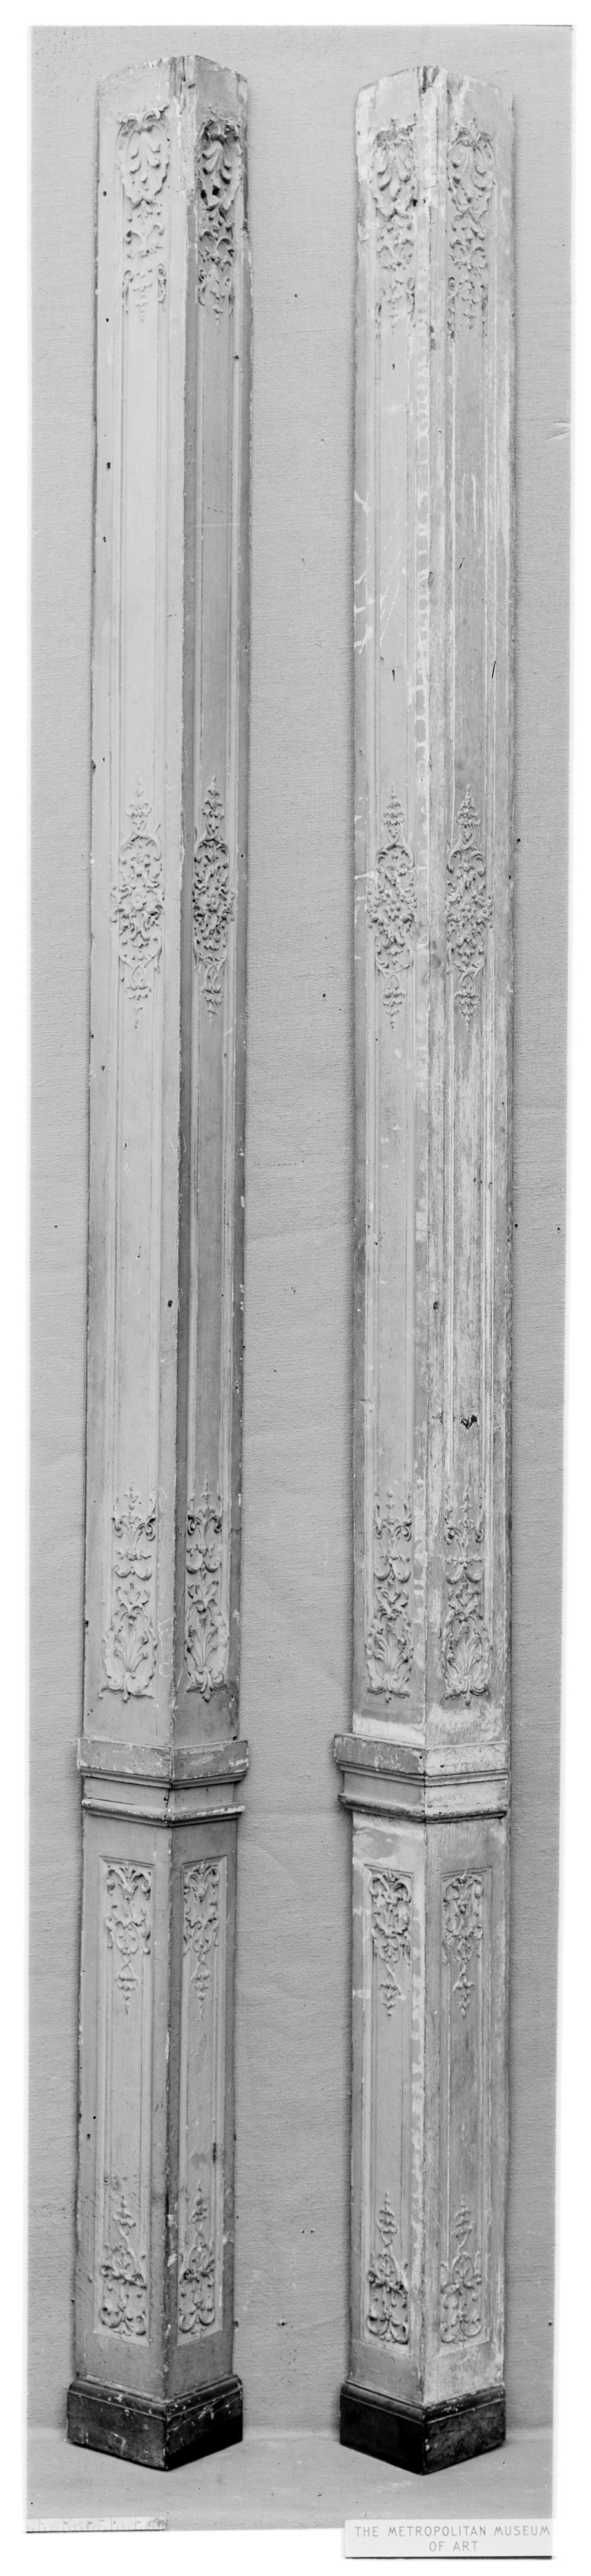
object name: pilaster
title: Pair of pilasters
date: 1701-1725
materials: wood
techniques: carving, painting